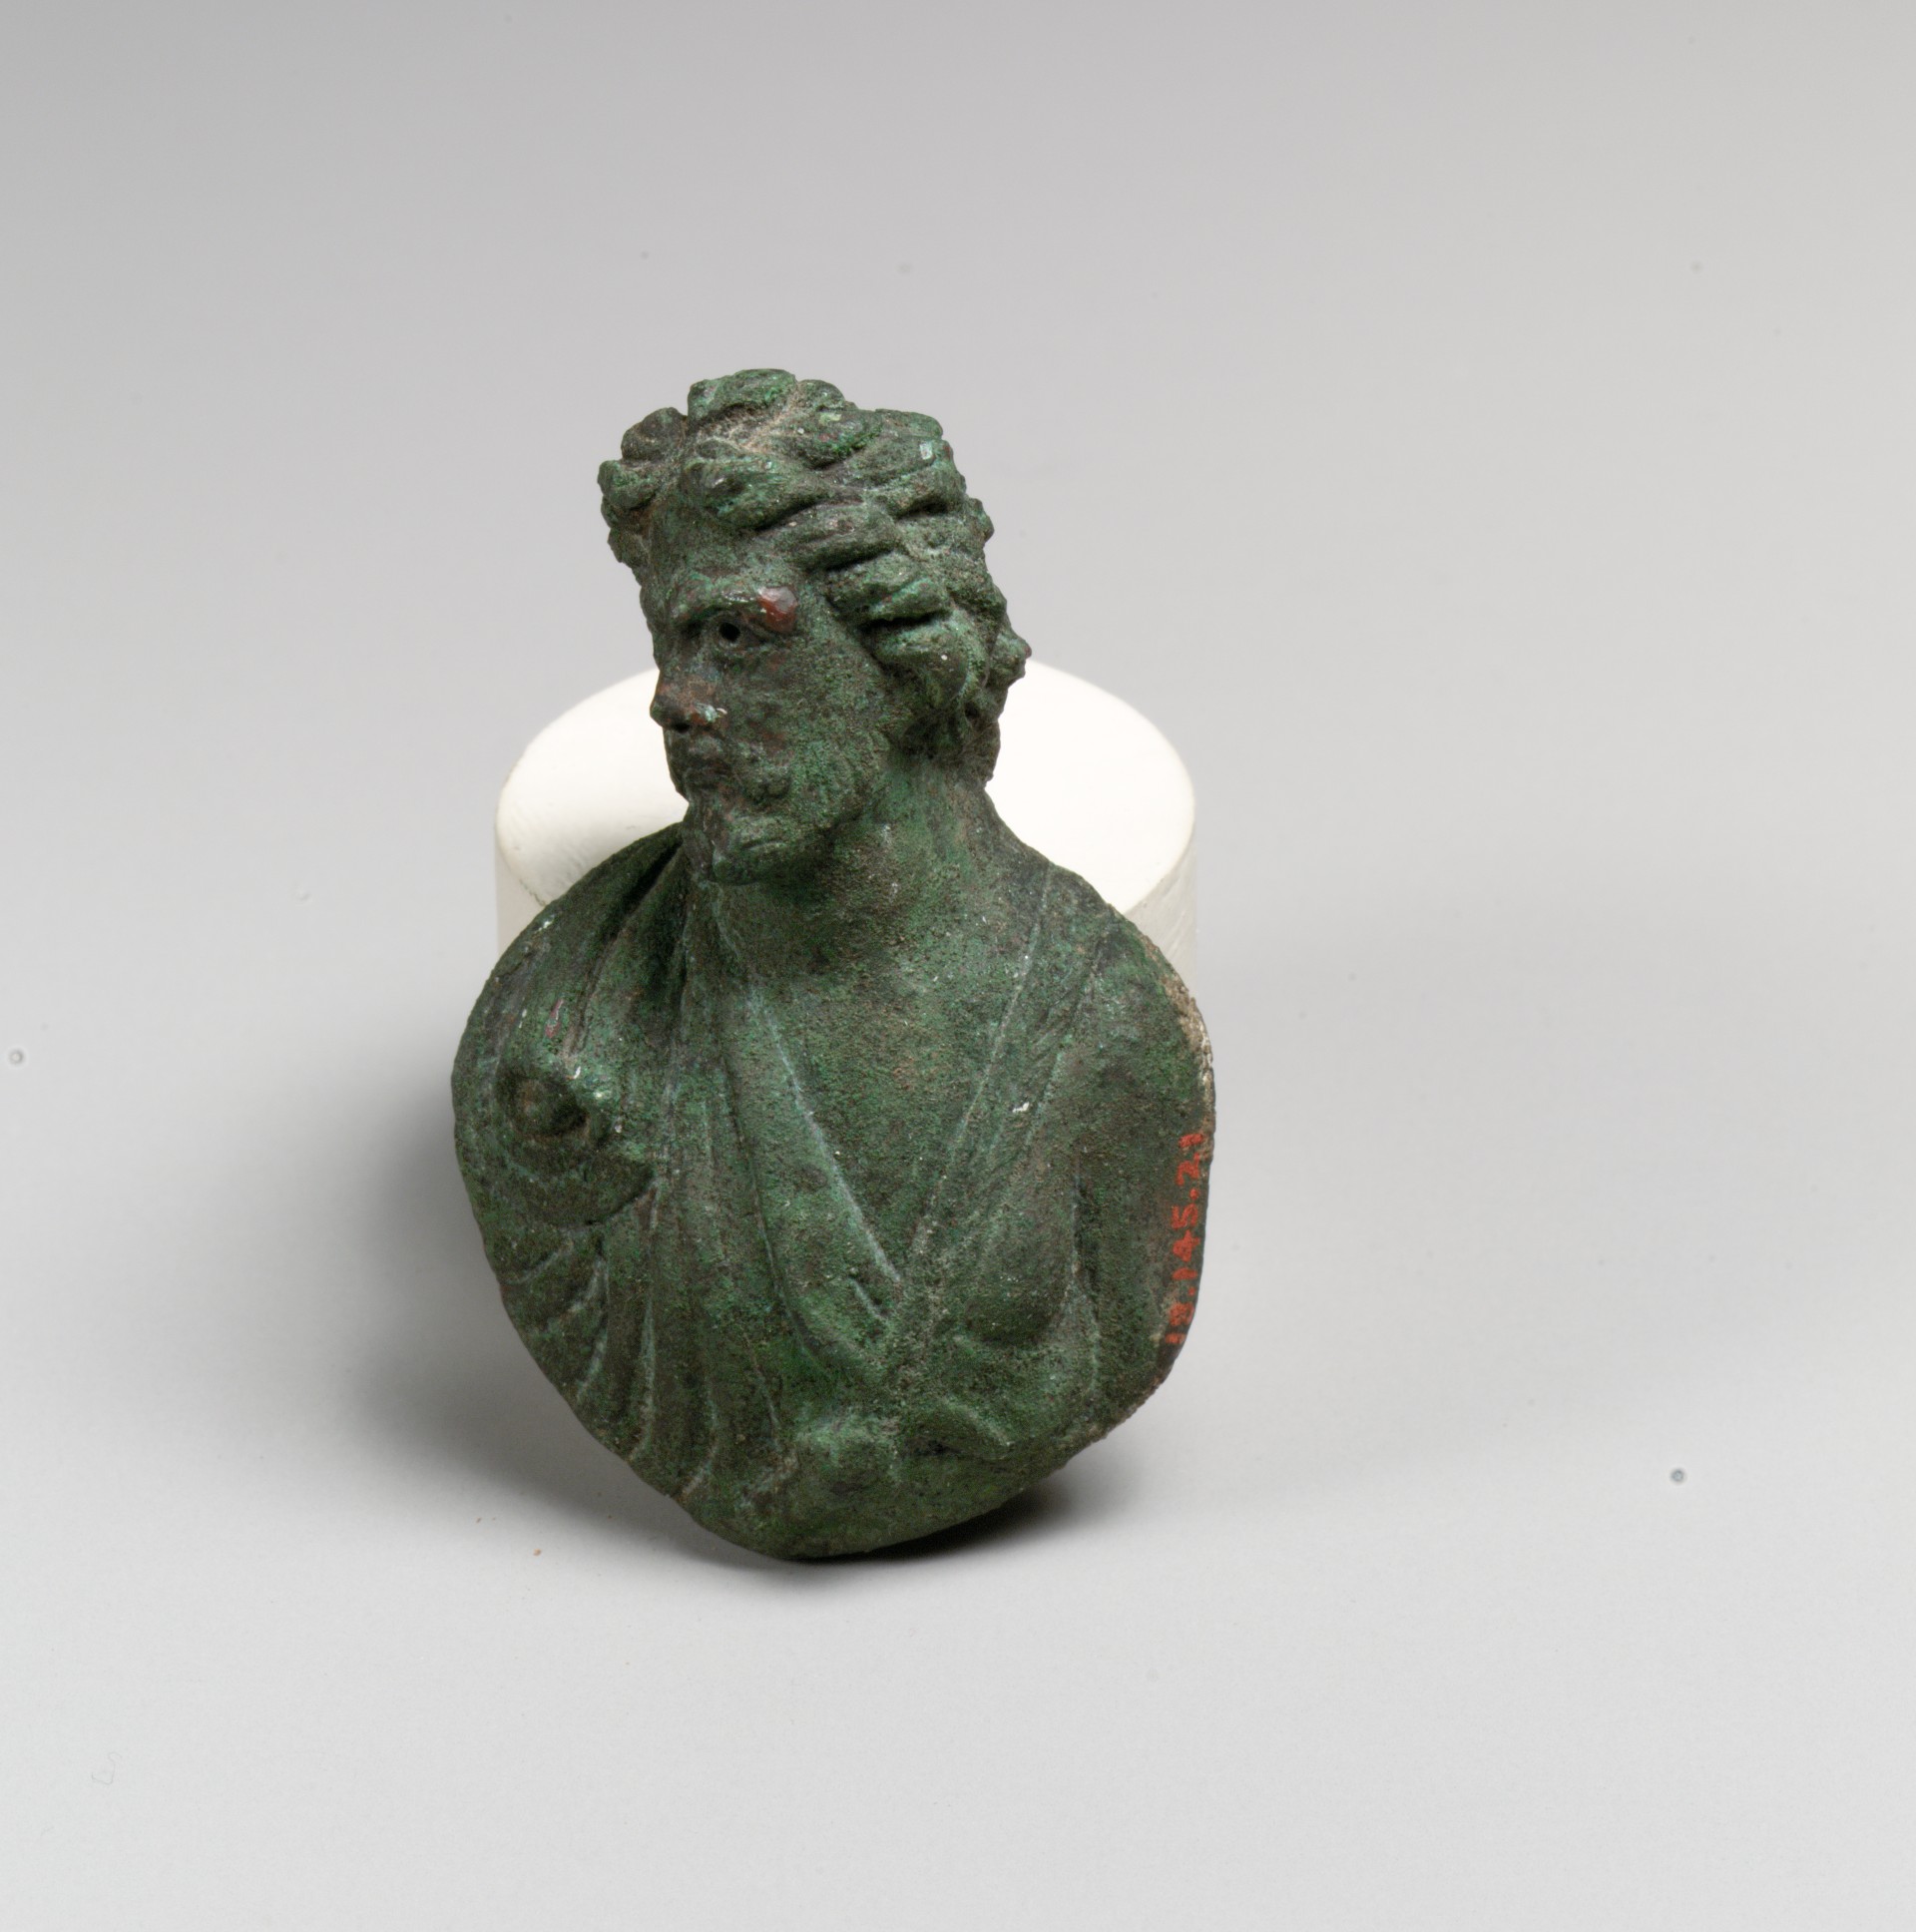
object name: bust of a barbarian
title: Bronze appliqué in the form of a bust of a barbarian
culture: roman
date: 67-200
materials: bronze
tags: men